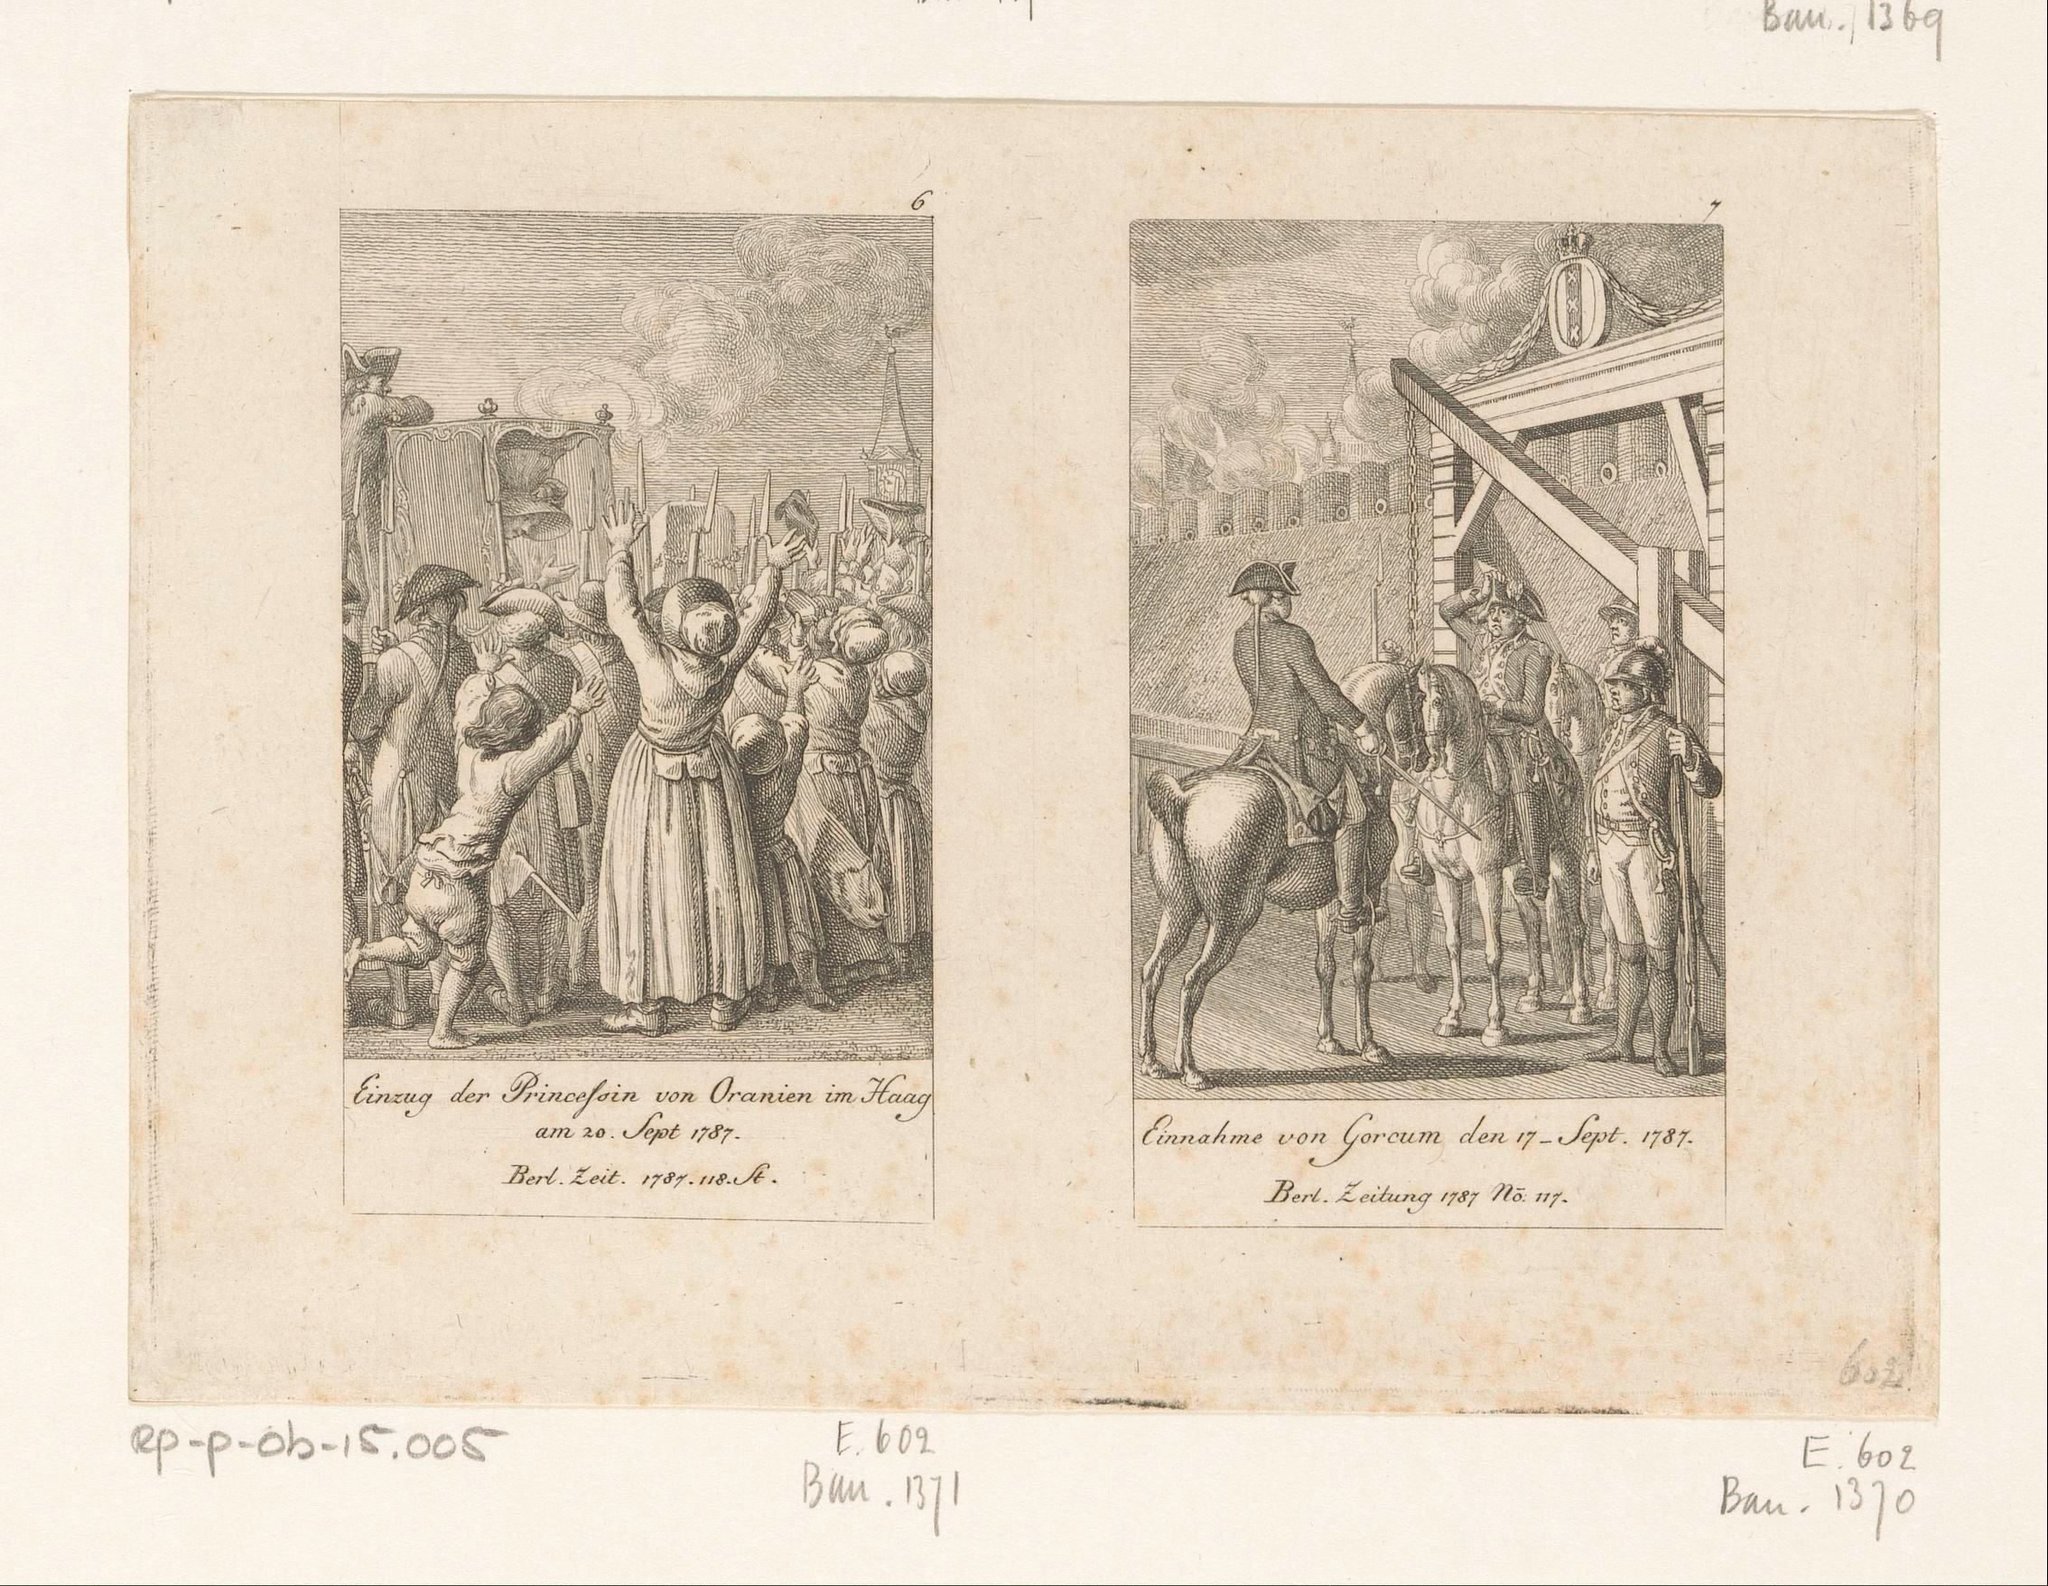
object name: print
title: Twee voorstellingen uit de Nederlandse oorlogsgeschiedenis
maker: daniel nikolaus chodowiecki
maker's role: draughtsman, print maker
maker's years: 1726-1801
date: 1788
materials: paper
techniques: etching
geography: germany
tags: crowd, mob, history, ruler, sovereign, city-gate, siege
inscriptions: collector's mark: Lugt 2228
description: Prenten gebruikt voor: Genealogischer-Militairischer Kalender auf das Jahr 1789. Berlijn: s.n., [1788].